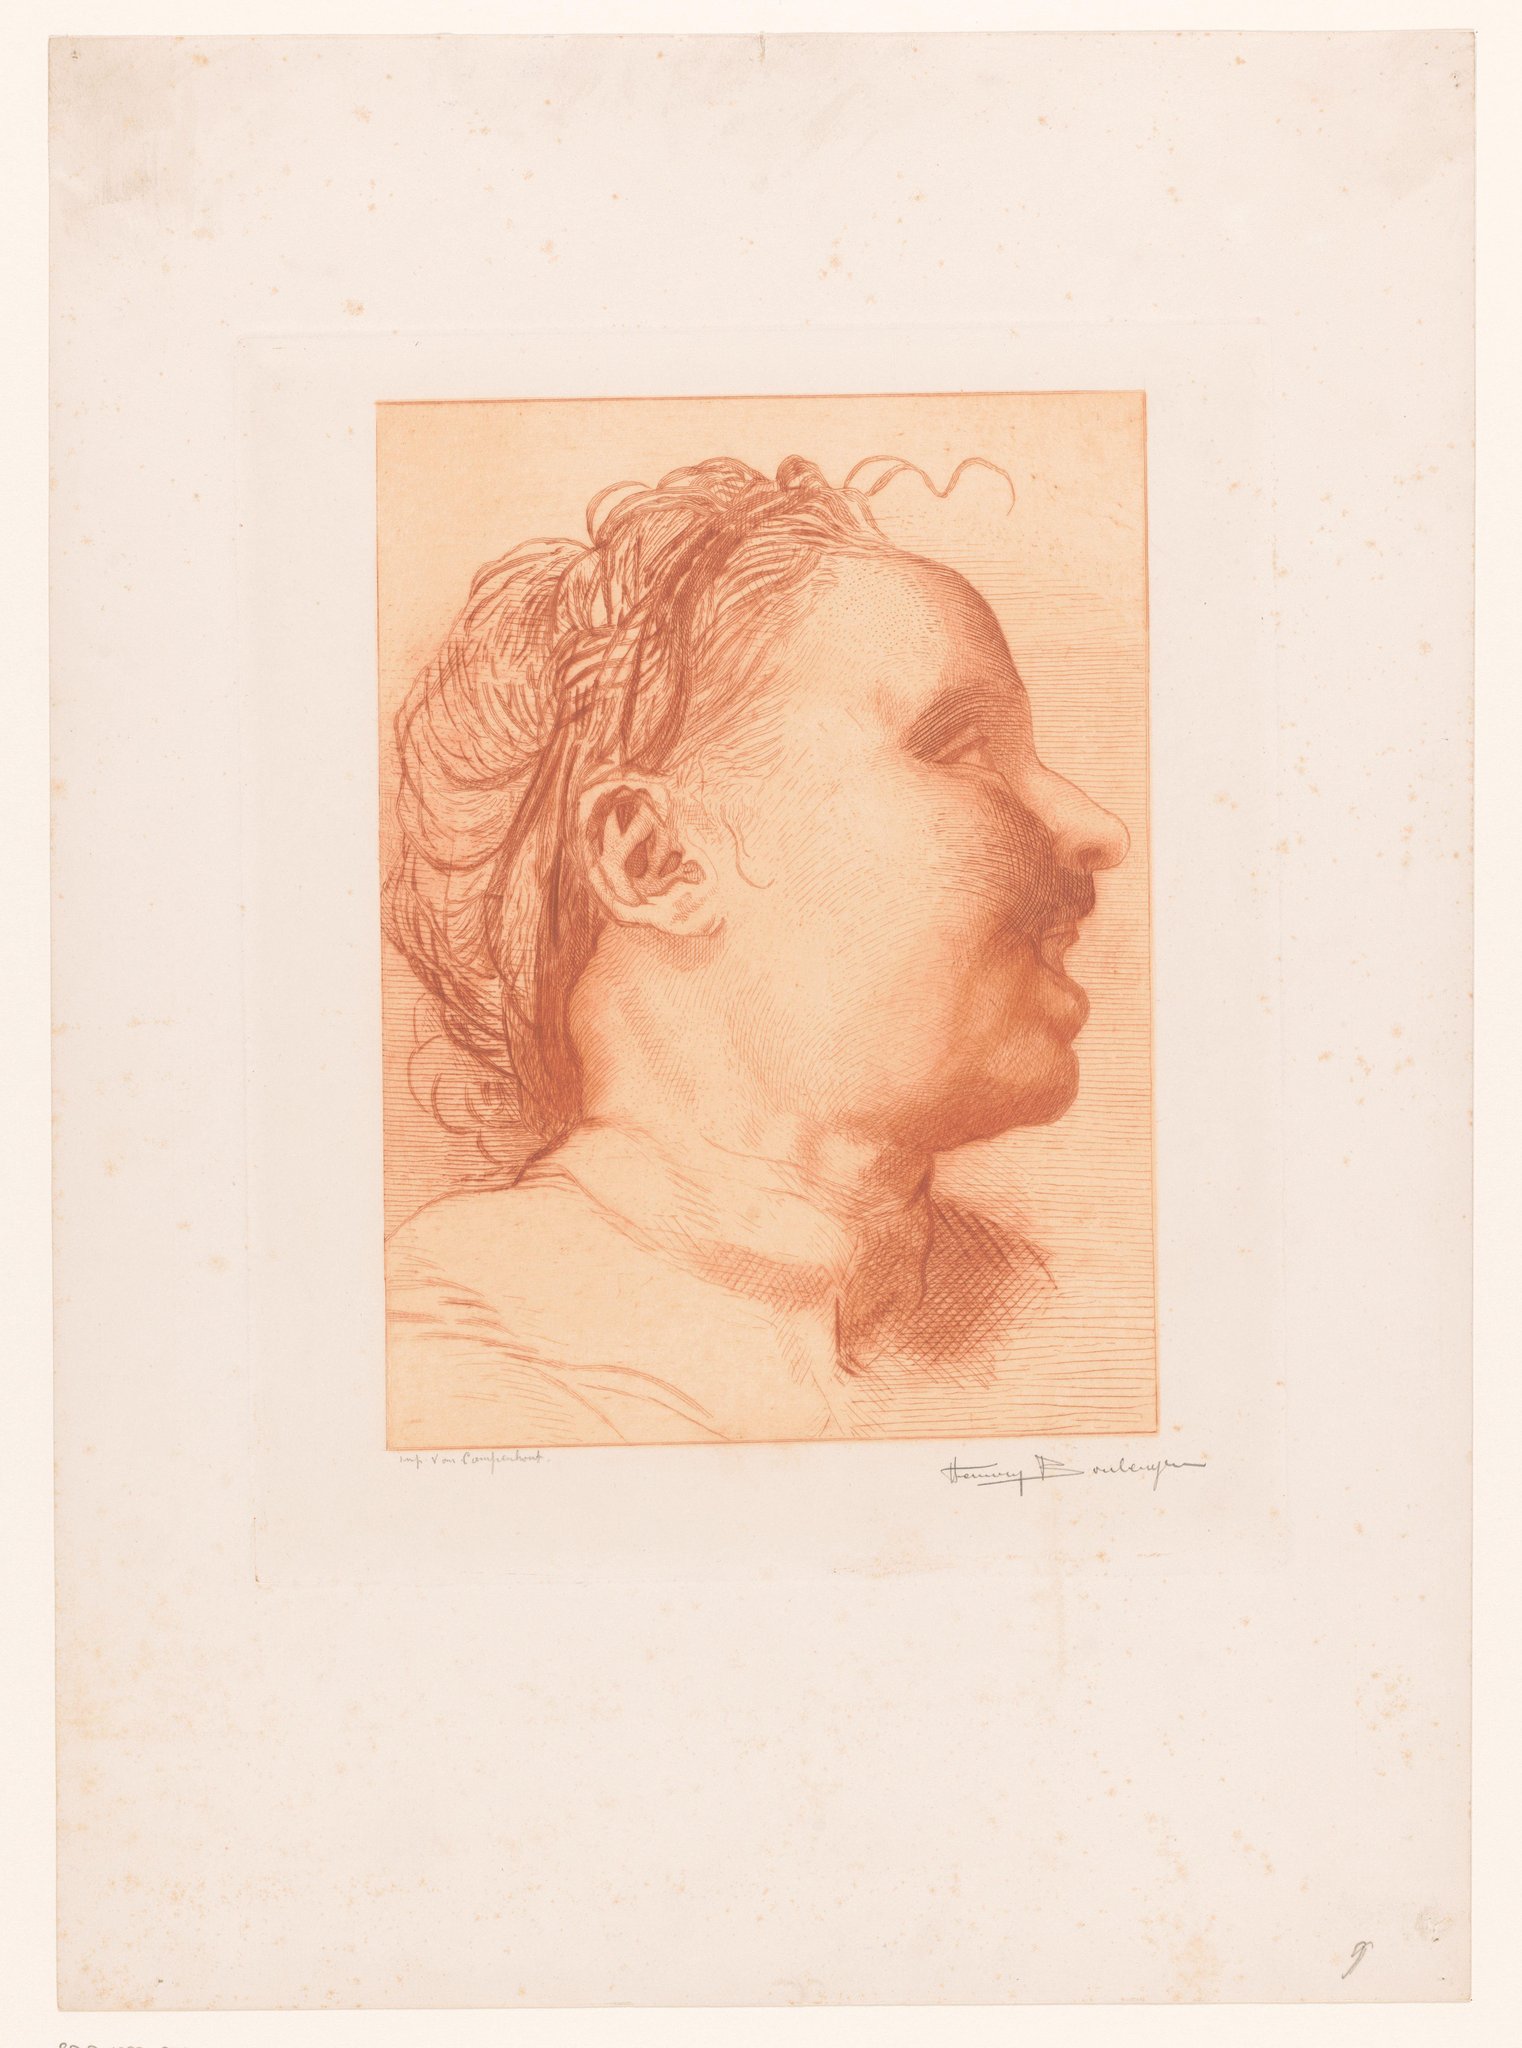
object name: print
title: Lachende vrouw kijkt schuin omhoog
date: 1880-1909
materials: paper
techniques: etching, intaglio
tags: laughing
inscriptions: collector's mark: Lugt 2228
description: Sterfdatum kunstenaar onbekend. Derhalve is voor bepaling van de rechten van dit object de verwervingsdatum aangehouden.